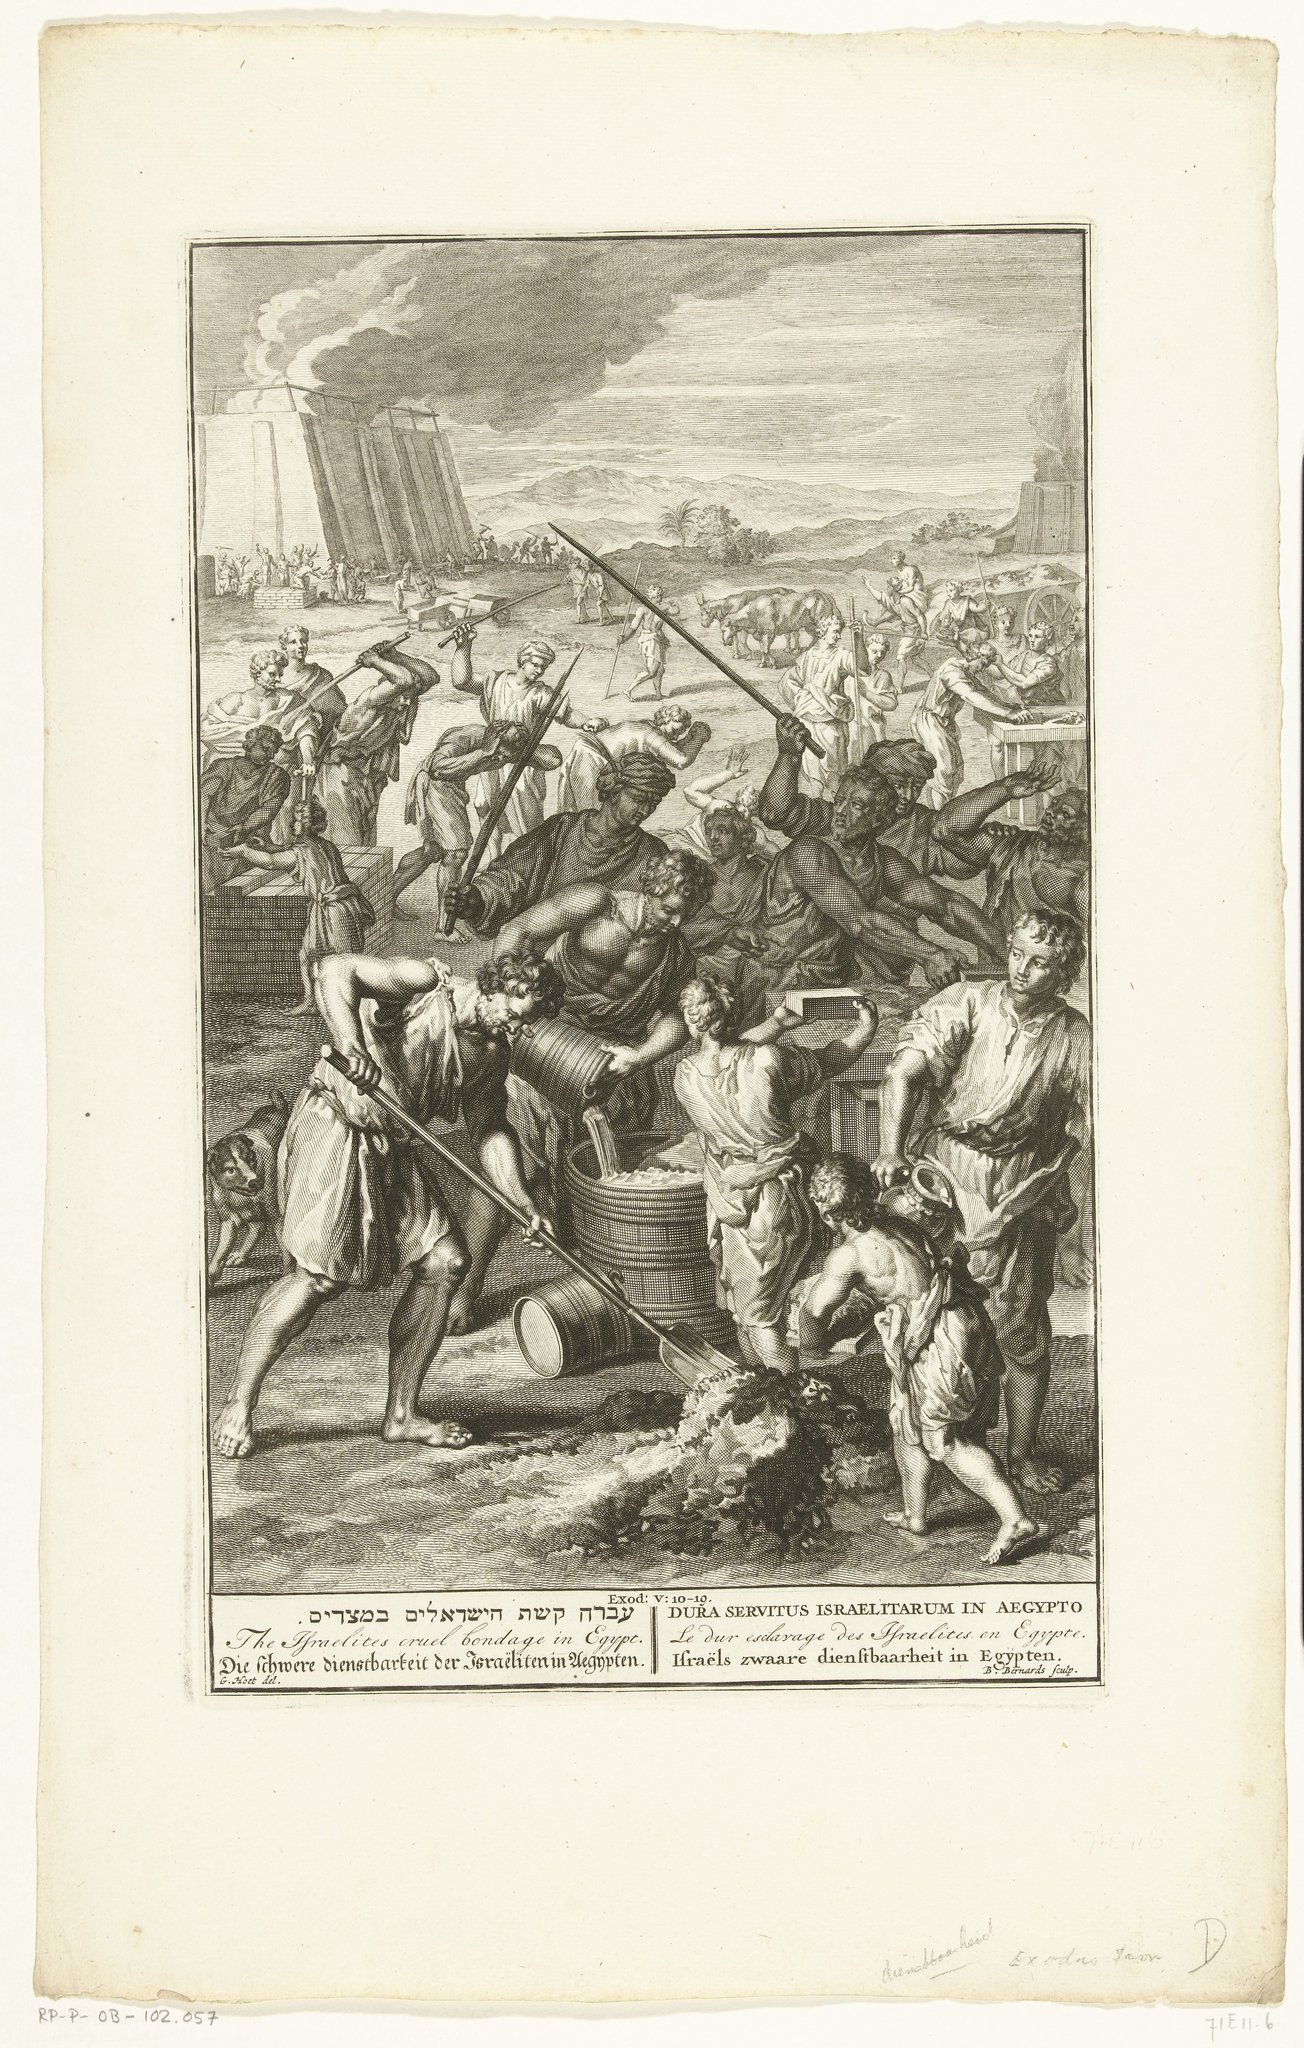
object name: book illustration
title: Israëlieten werken voor de farao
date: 1720-1728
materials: paper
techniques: engraving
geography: amsterdam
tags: pharaoh commands the taskmasters to stop supplying the people with straw for making bricks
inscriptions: collector's mark: Lugt 2228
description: Prent gemaakt voor: Figures de la Bible. Amsterdam, Bernard Picart, 1720. Prent ook gebruikt in: Taferelen der voornaamste geschiedenissen van het Oude en Nieuwe Testament (...) door de vermaarde kunstenaars Hoet, Houbraken, en Picart getekent (...) en met beschrijvingen uitgebreid. Den Haag: Pieter de Hondt, 1728.